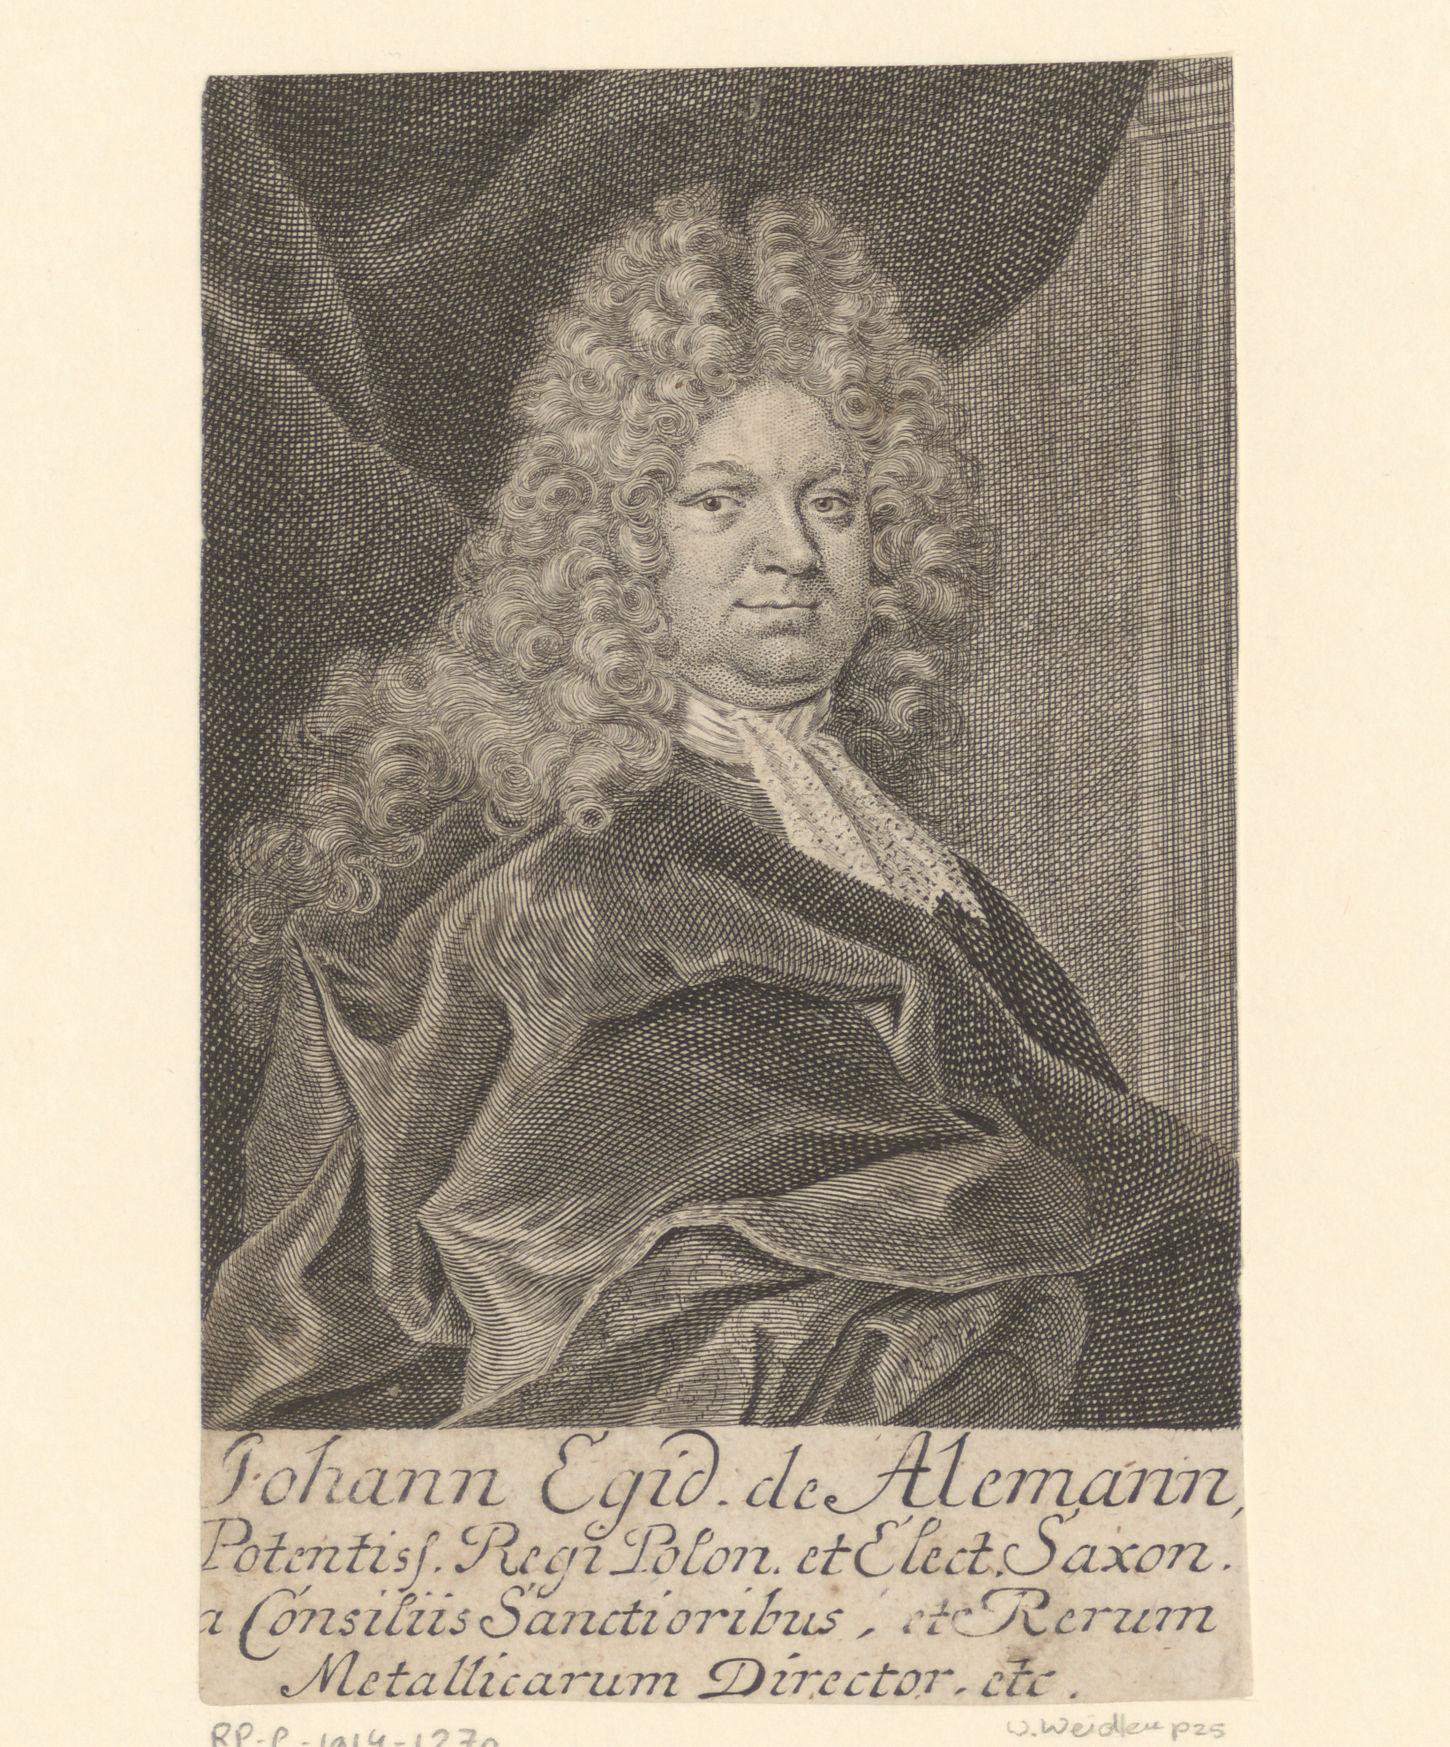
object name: print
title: Portret van Johann Ägidius von Alemann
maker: martin bernigeroth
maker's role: print maker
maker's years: 1670-1733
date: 1713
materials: paper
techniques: engraving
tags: historical persons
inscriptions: collector's mark: Lugt 2228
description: Prent ook gebruikt in: Die Europäische Fama, Welche den gegenwärtigen Zustand der vornehmsten Höfe entdecket. dl. 145. Leipzig: Gleditsch, 1713.